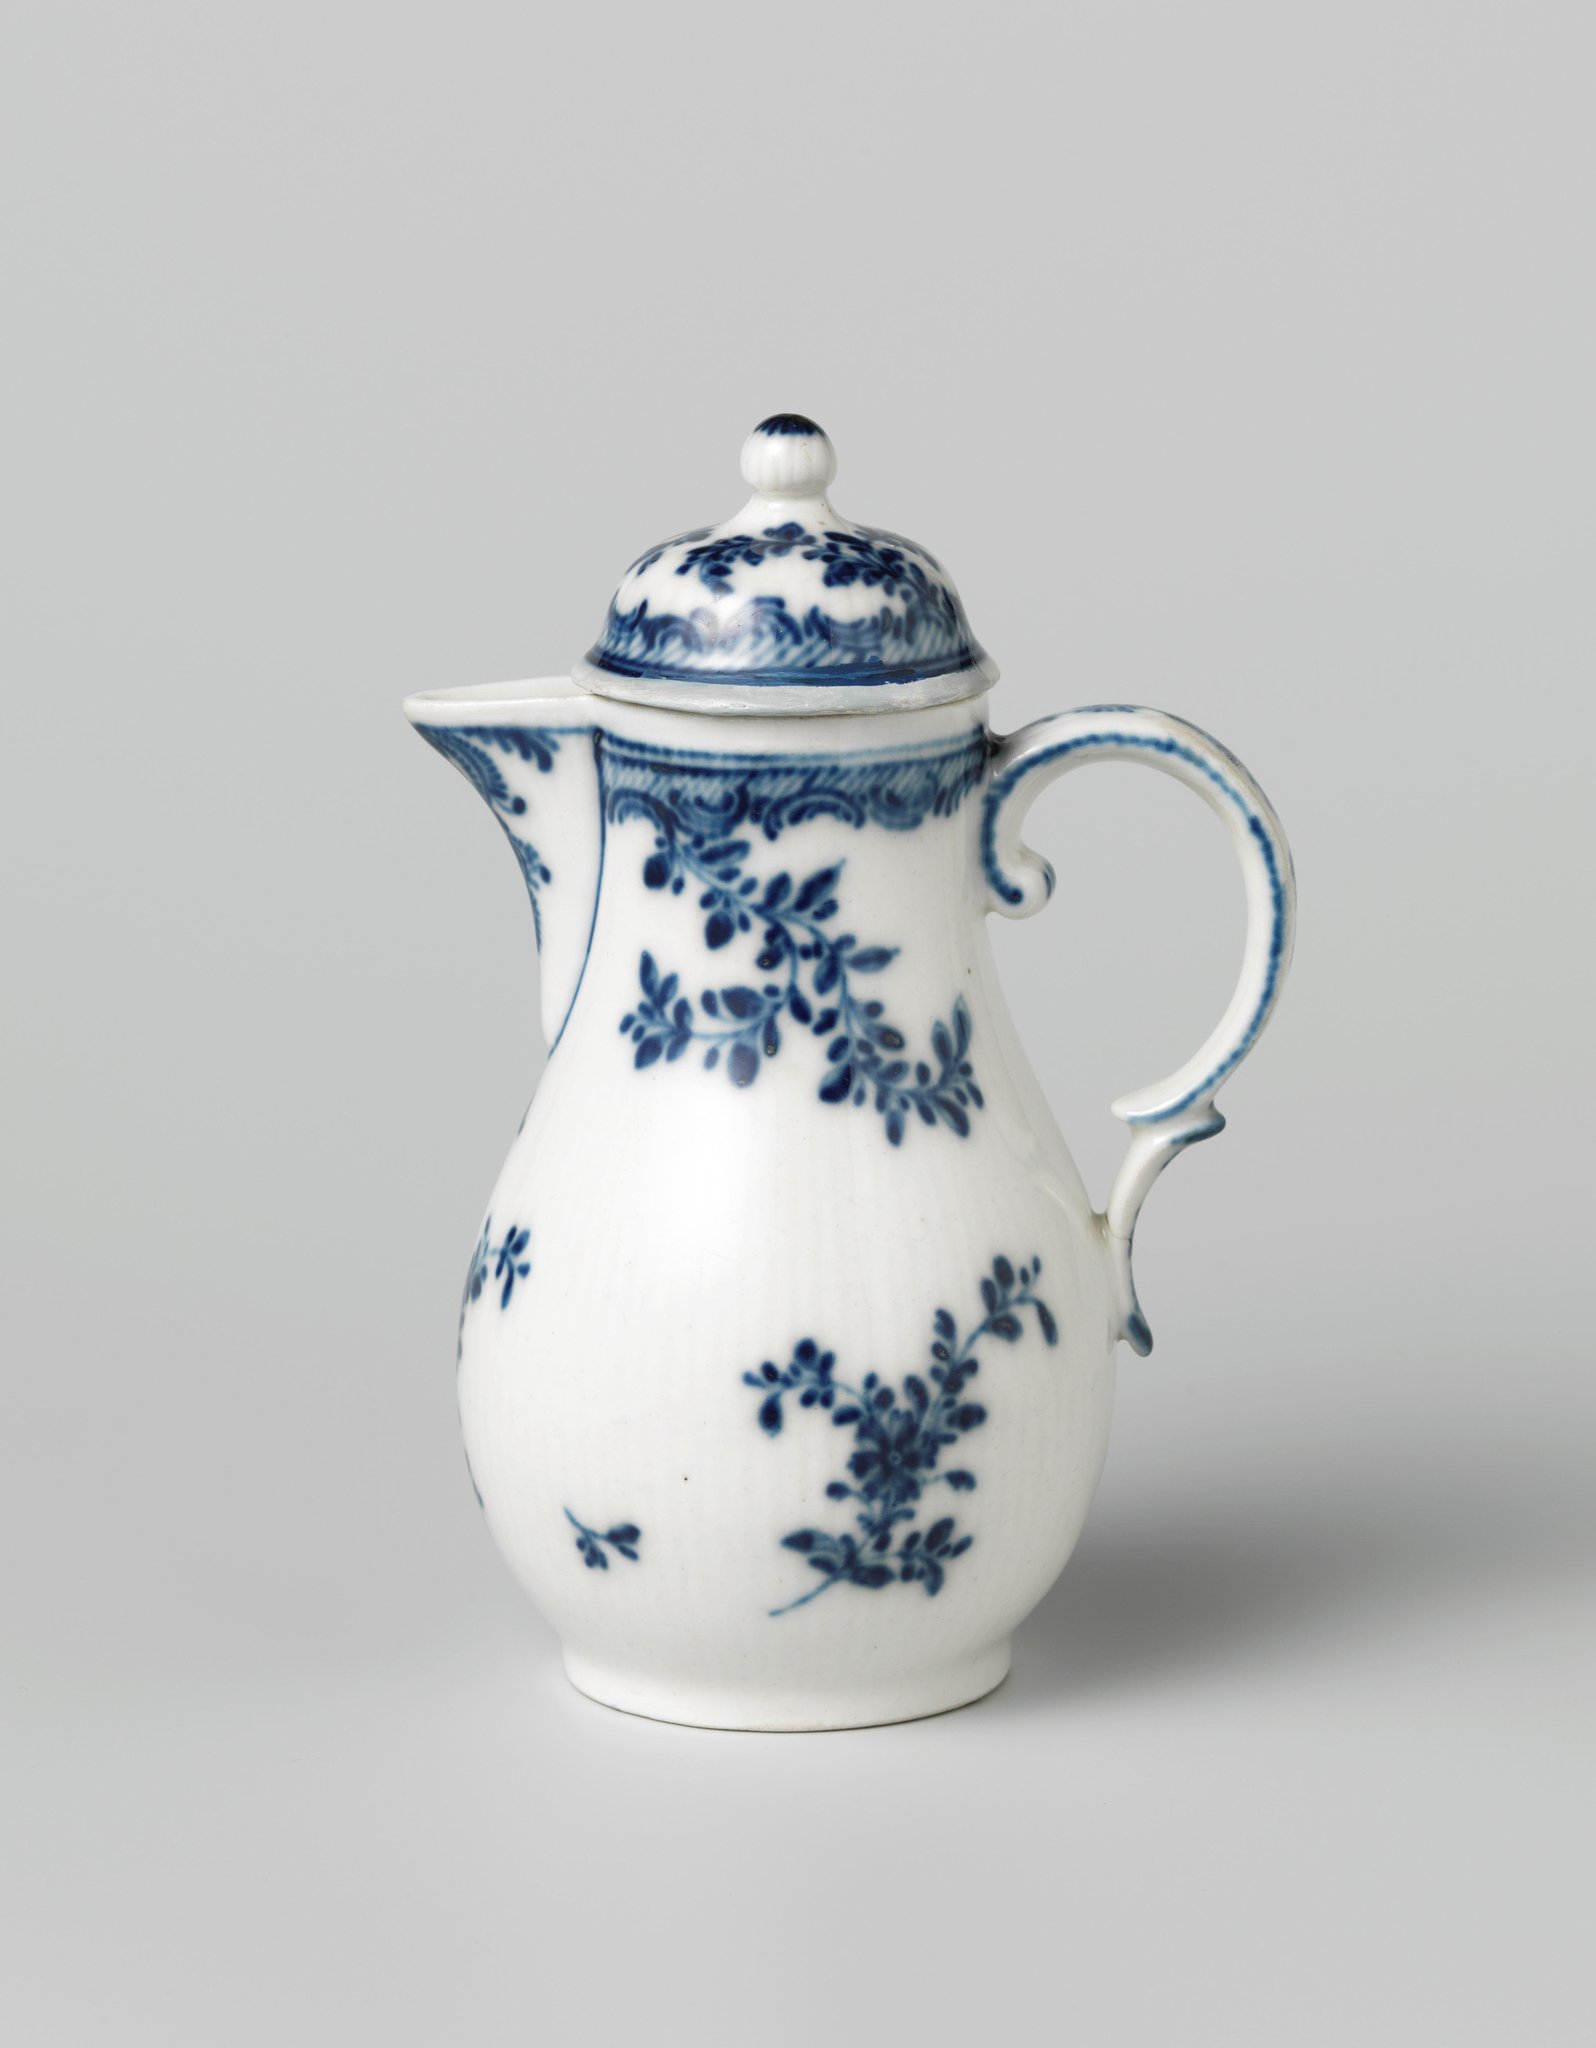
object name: milk jug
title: Melkkan, beschilderd met bloemtakken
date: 1778-1782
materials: porcelain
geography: loosdrecht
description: Melkkan van porselein. Kan versierd met ribben in reliëf in twee (deksel) of drie (kan) verspringende rijen. Beschilderd in onderglazuurblauw met bloemtakken, die bij de mondrand afhangen van een geschilderde rocaillerand. Op de tuit spiraalvormige motieven, op het oor een bladslinger, beide in dezelfde kleur.